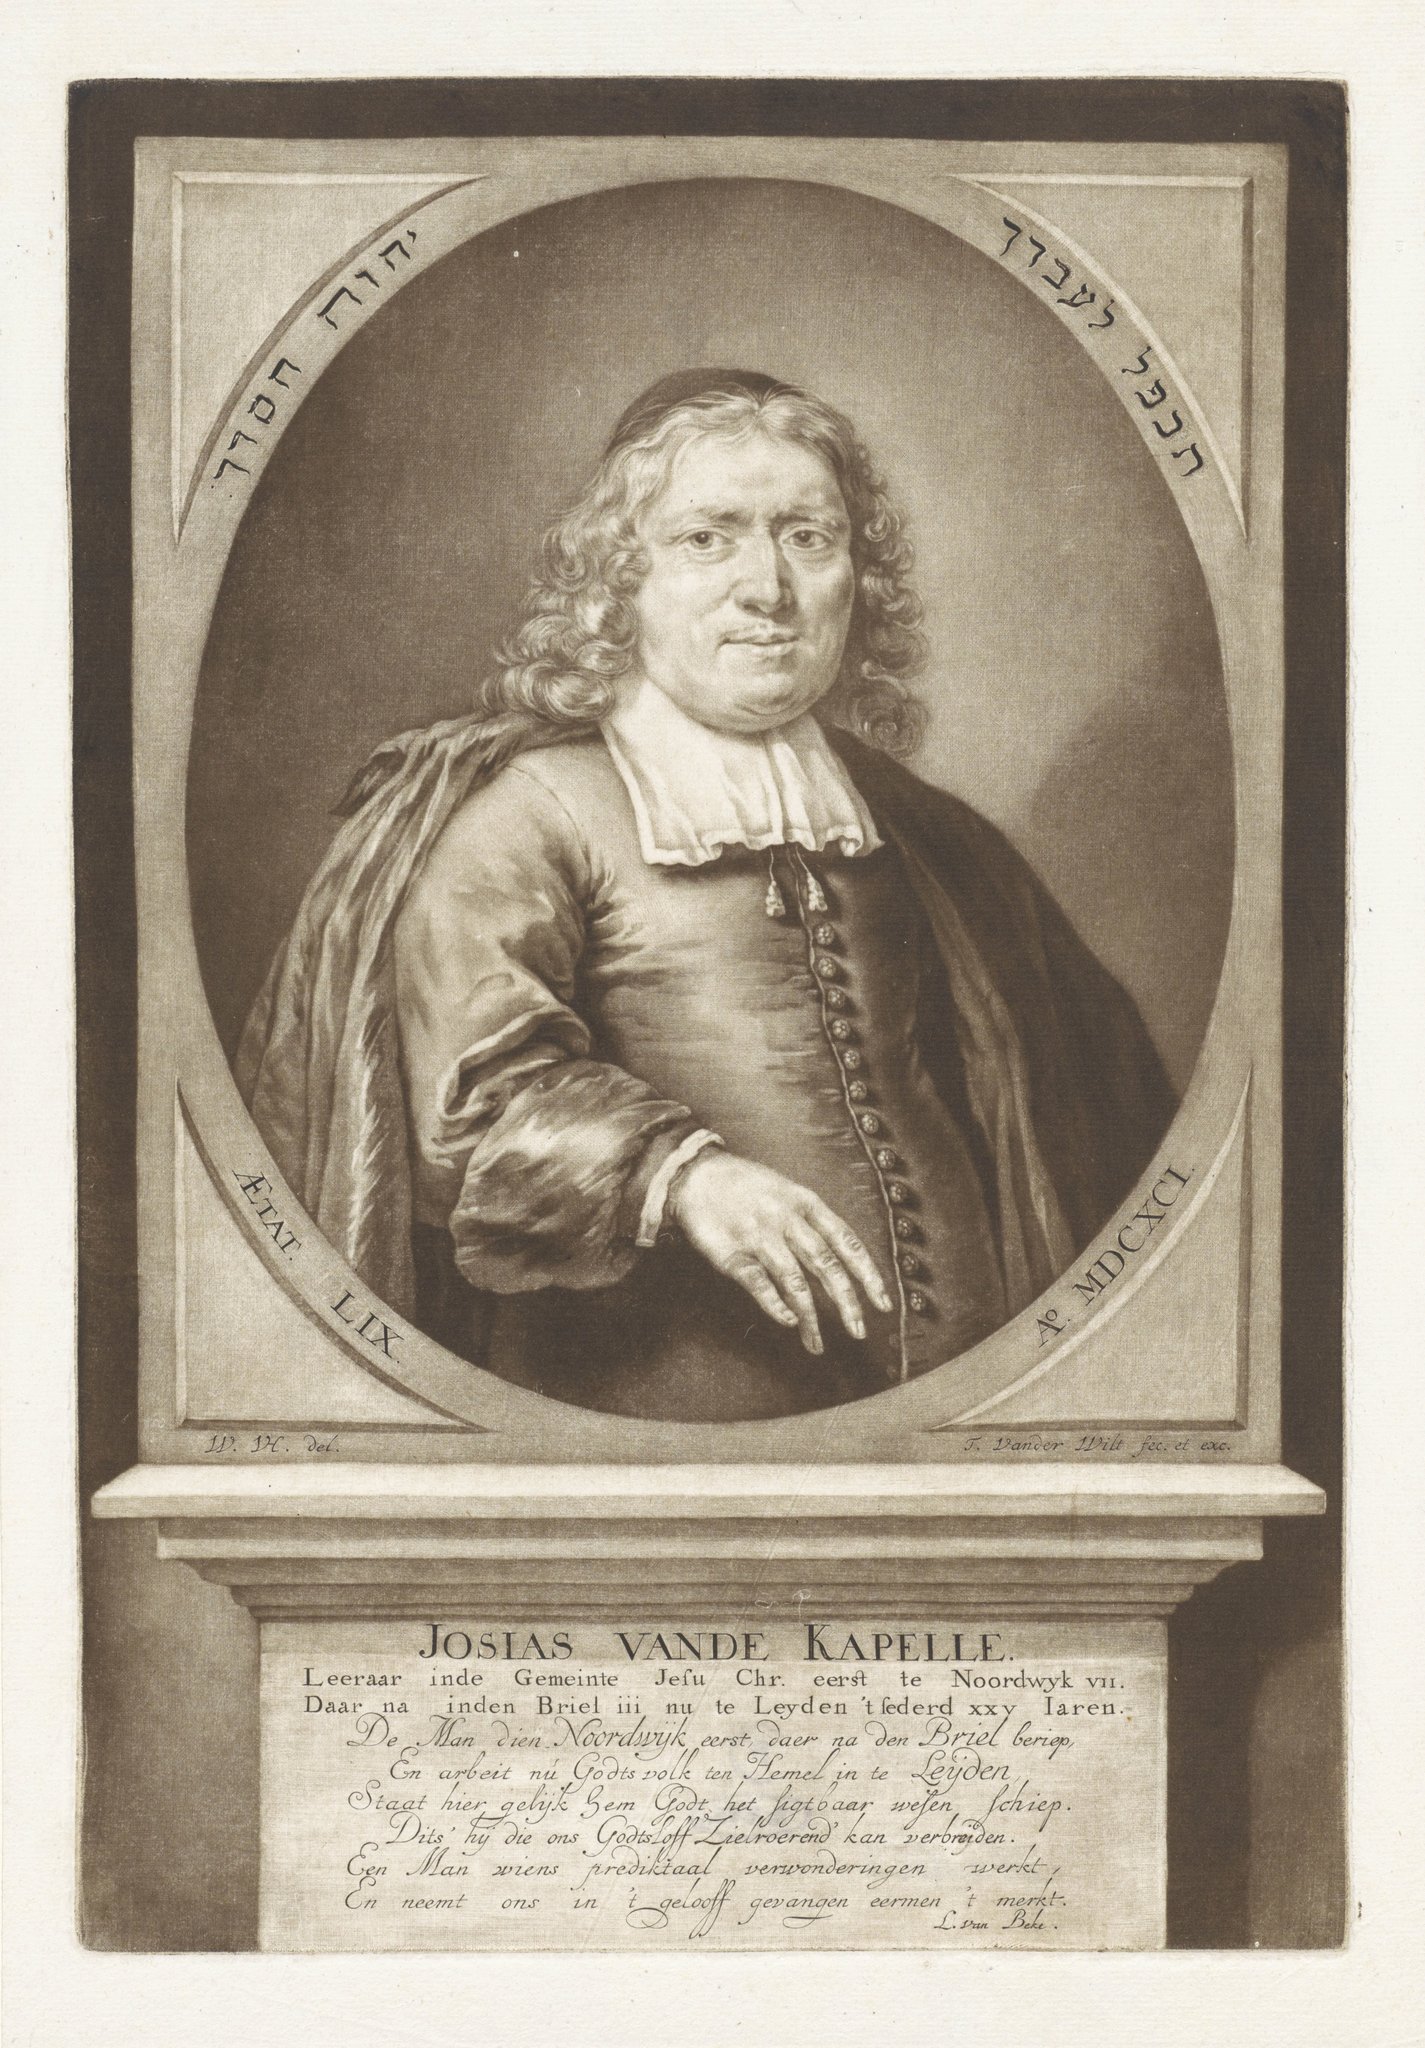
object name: print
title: Portret van de predikant Josias van der Kapelle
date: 1691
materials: paper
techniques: mezzotint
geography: delft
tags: leiden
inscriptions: collector's mark: Lugt 964